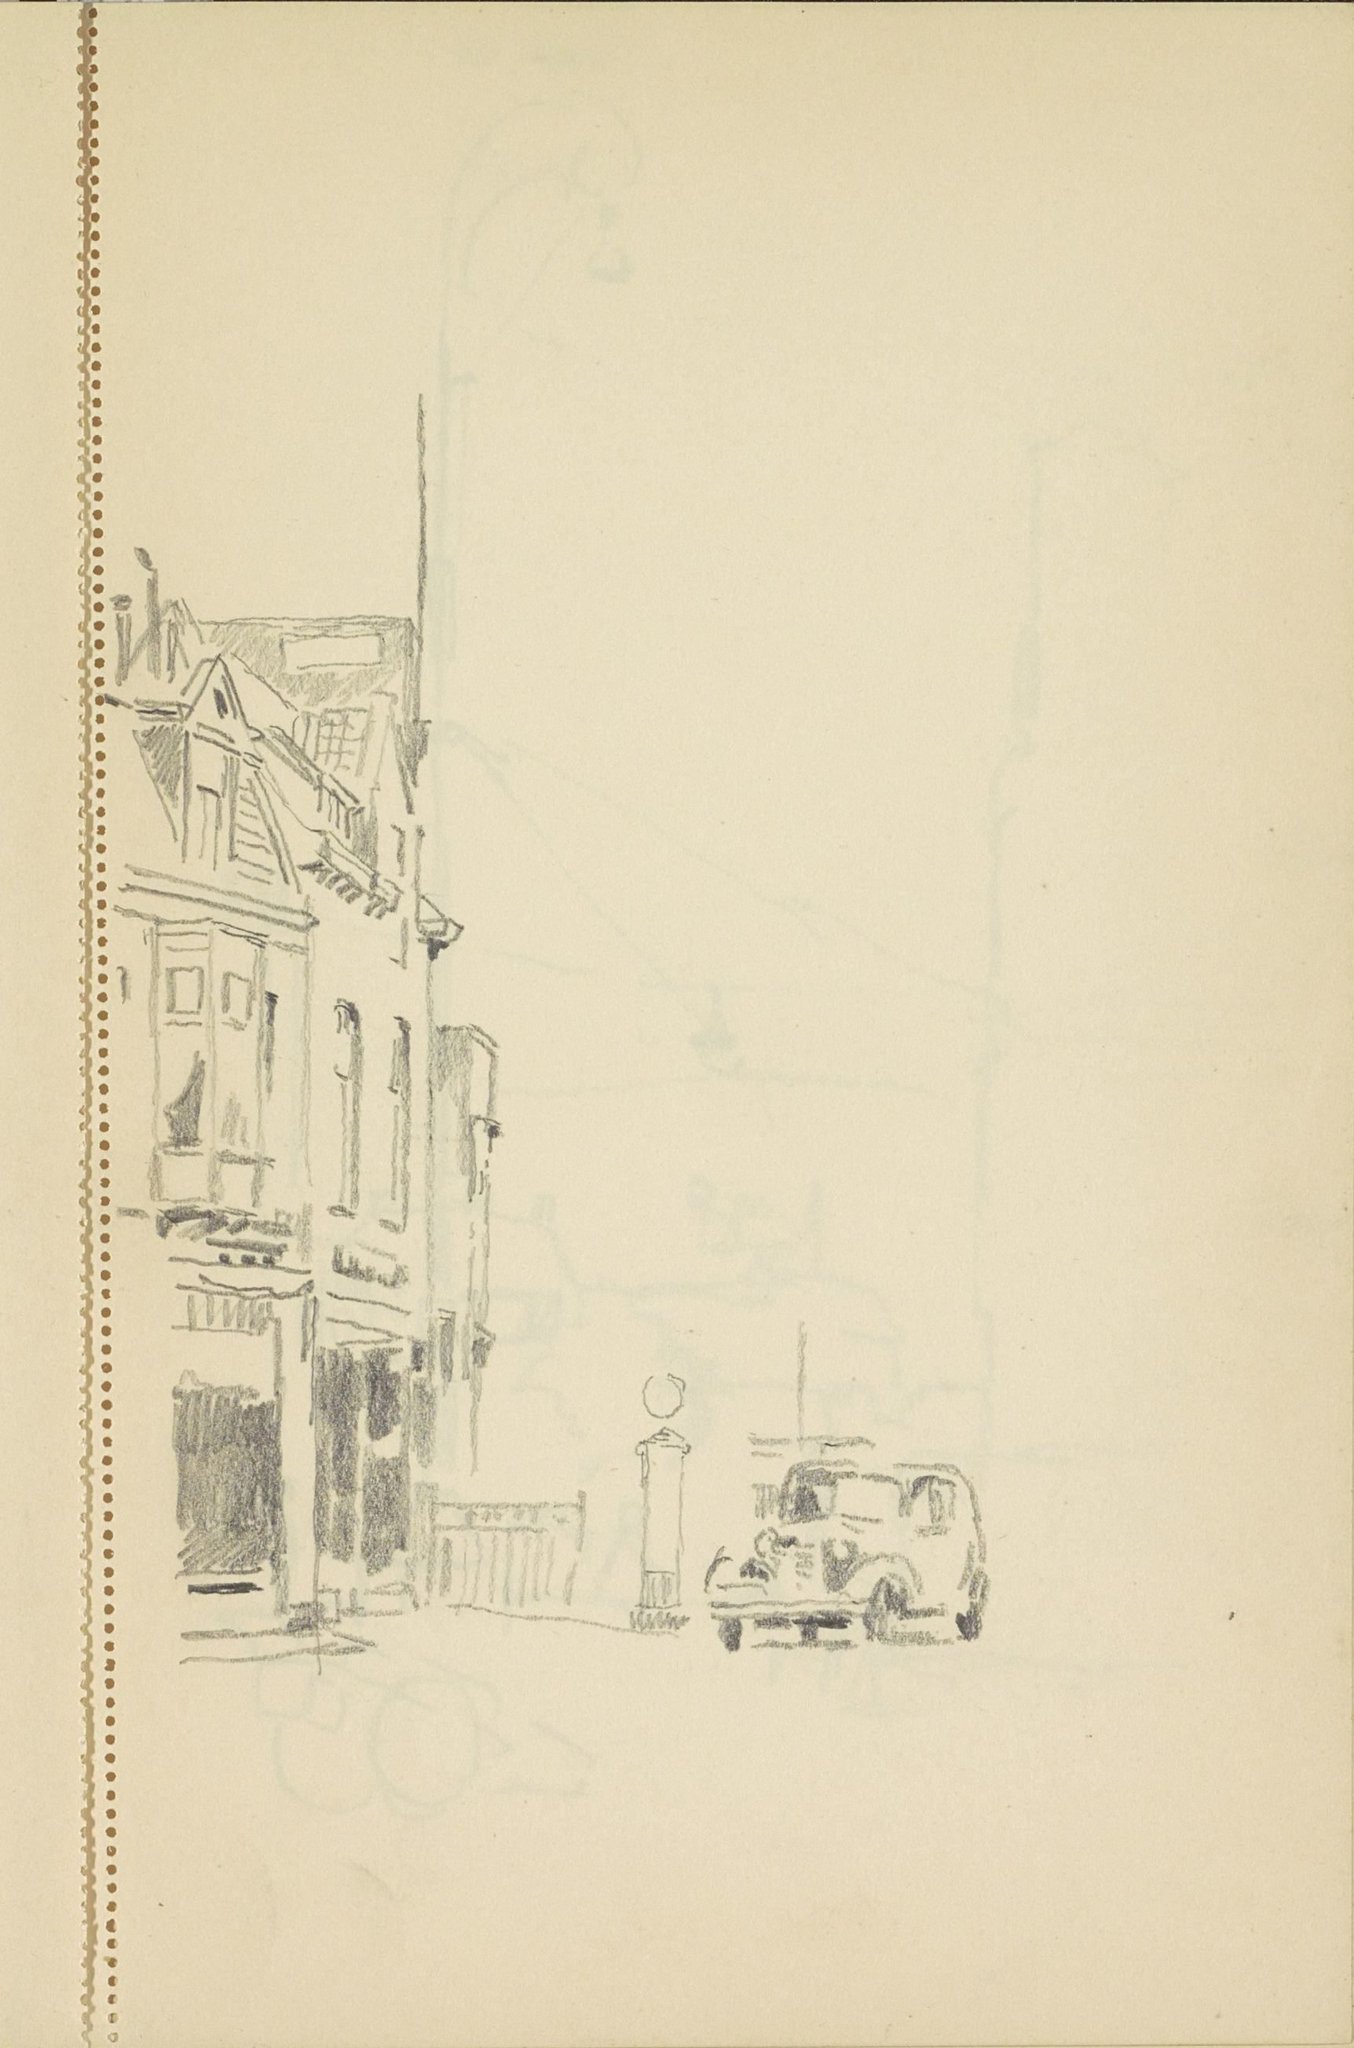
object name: sketchbook leaf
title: Auto op een straat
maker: cornelis vreedenburgh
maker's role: draughtsman, print maker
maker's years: 1880-1946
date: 1890-1946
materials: paper, pencil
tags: automobile, street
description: Blad 33 recto uit een schetsboek met 73 bladen.